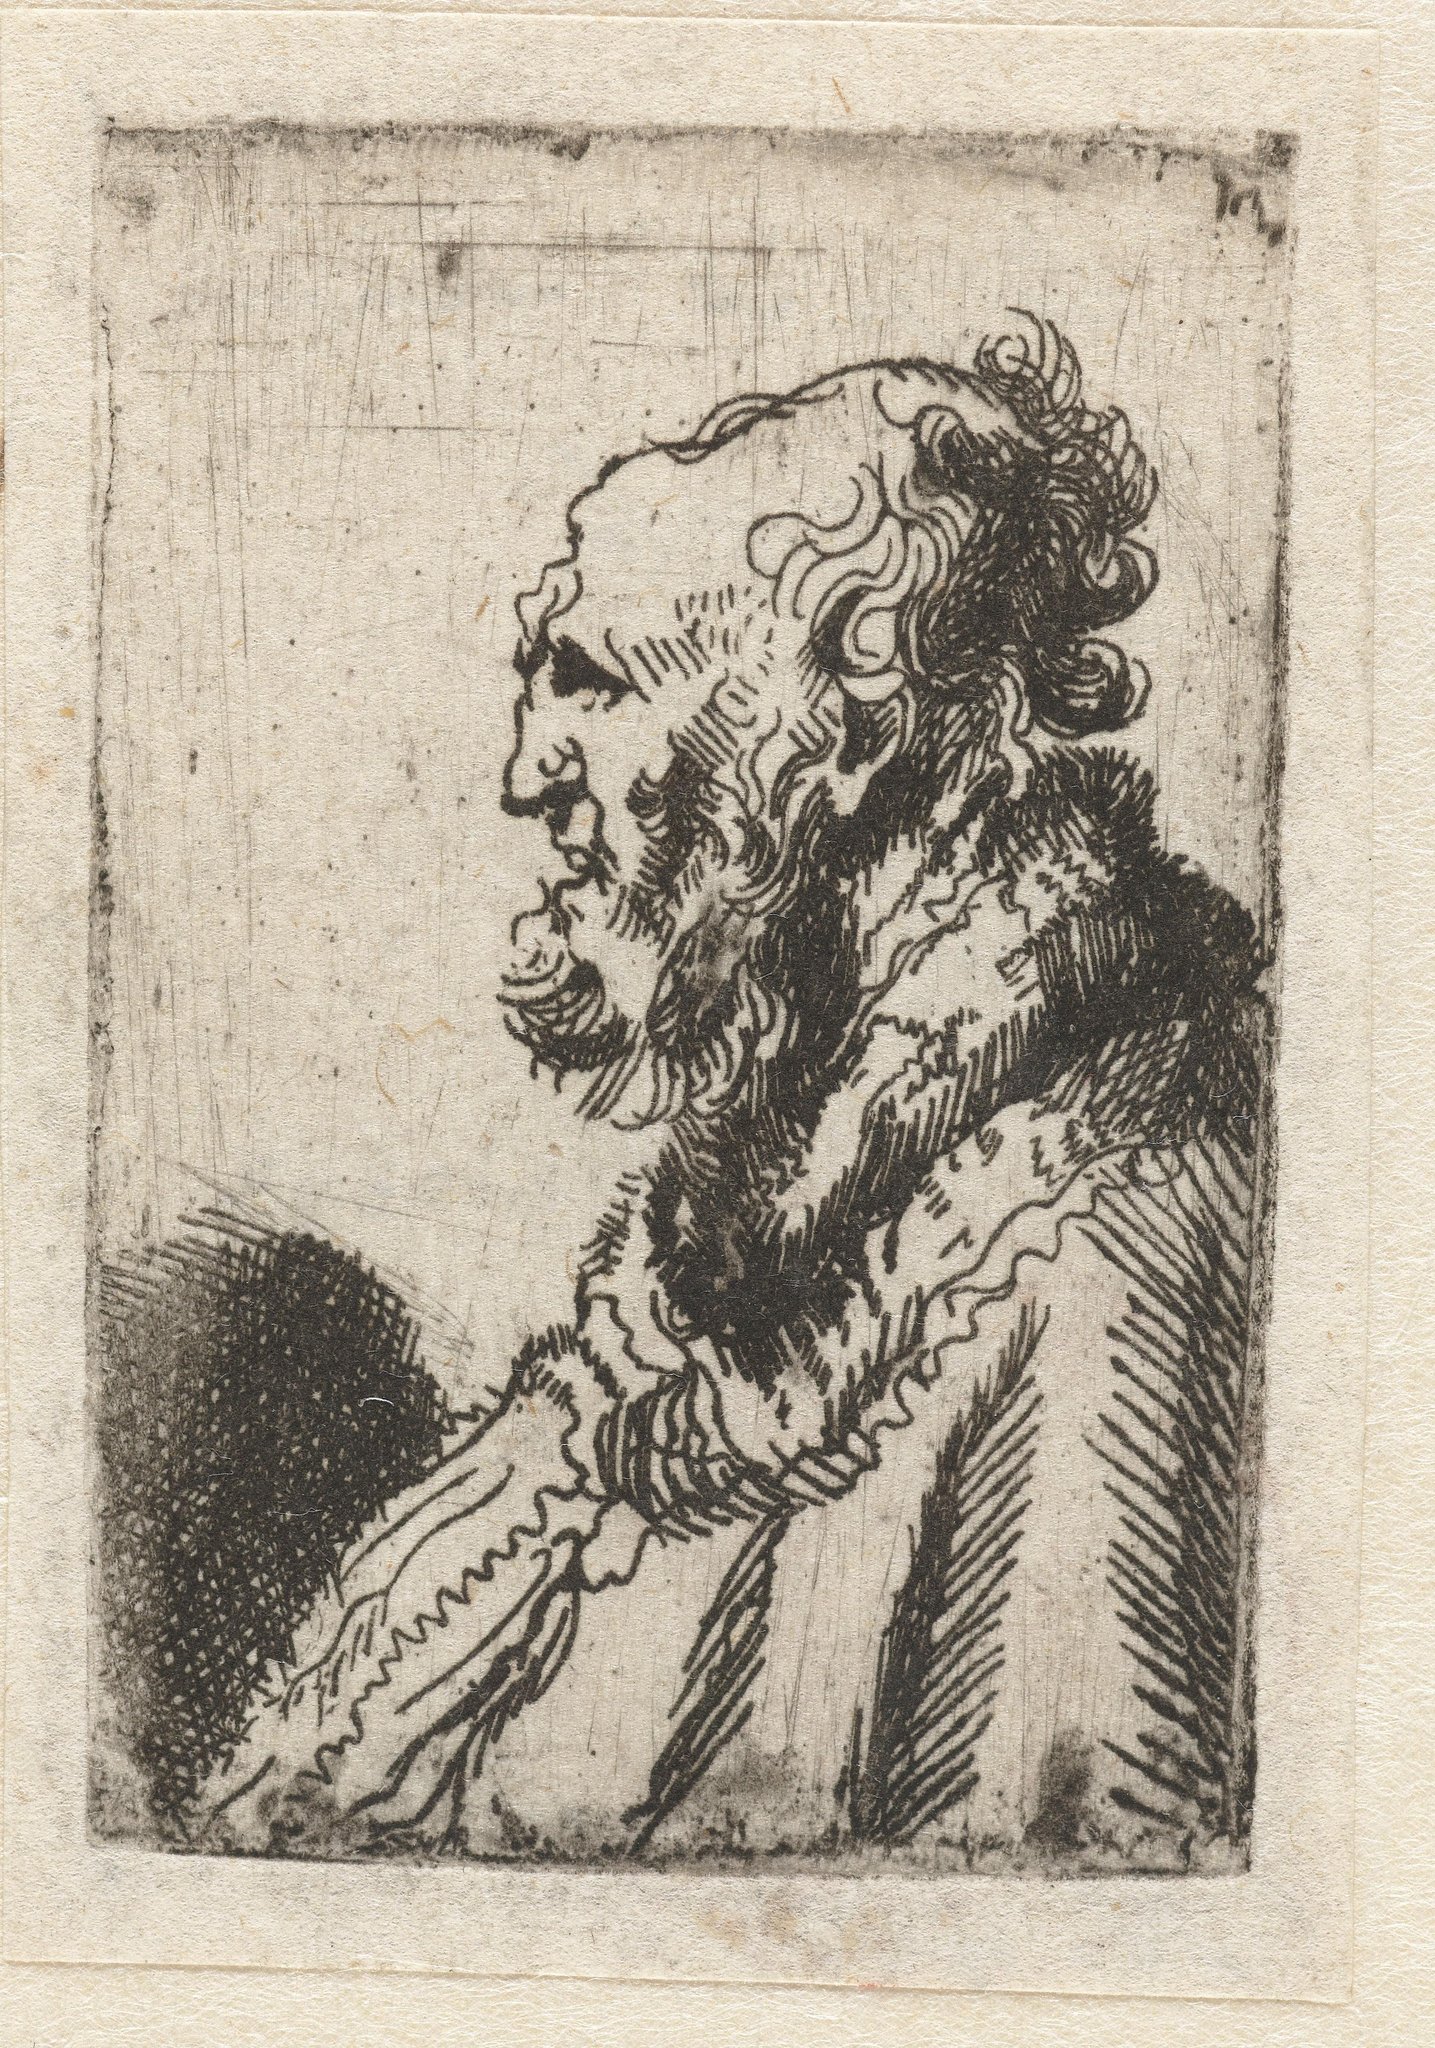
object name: print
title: Bald old man with a short beard, in profile right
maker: Anonymous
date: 1635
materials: paper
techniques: etching, intaglio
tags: old man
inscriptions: collector's mark: Lugt 240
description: Spiegelbeeldige kopie naar de gelijknamige prent van Rembrandt.